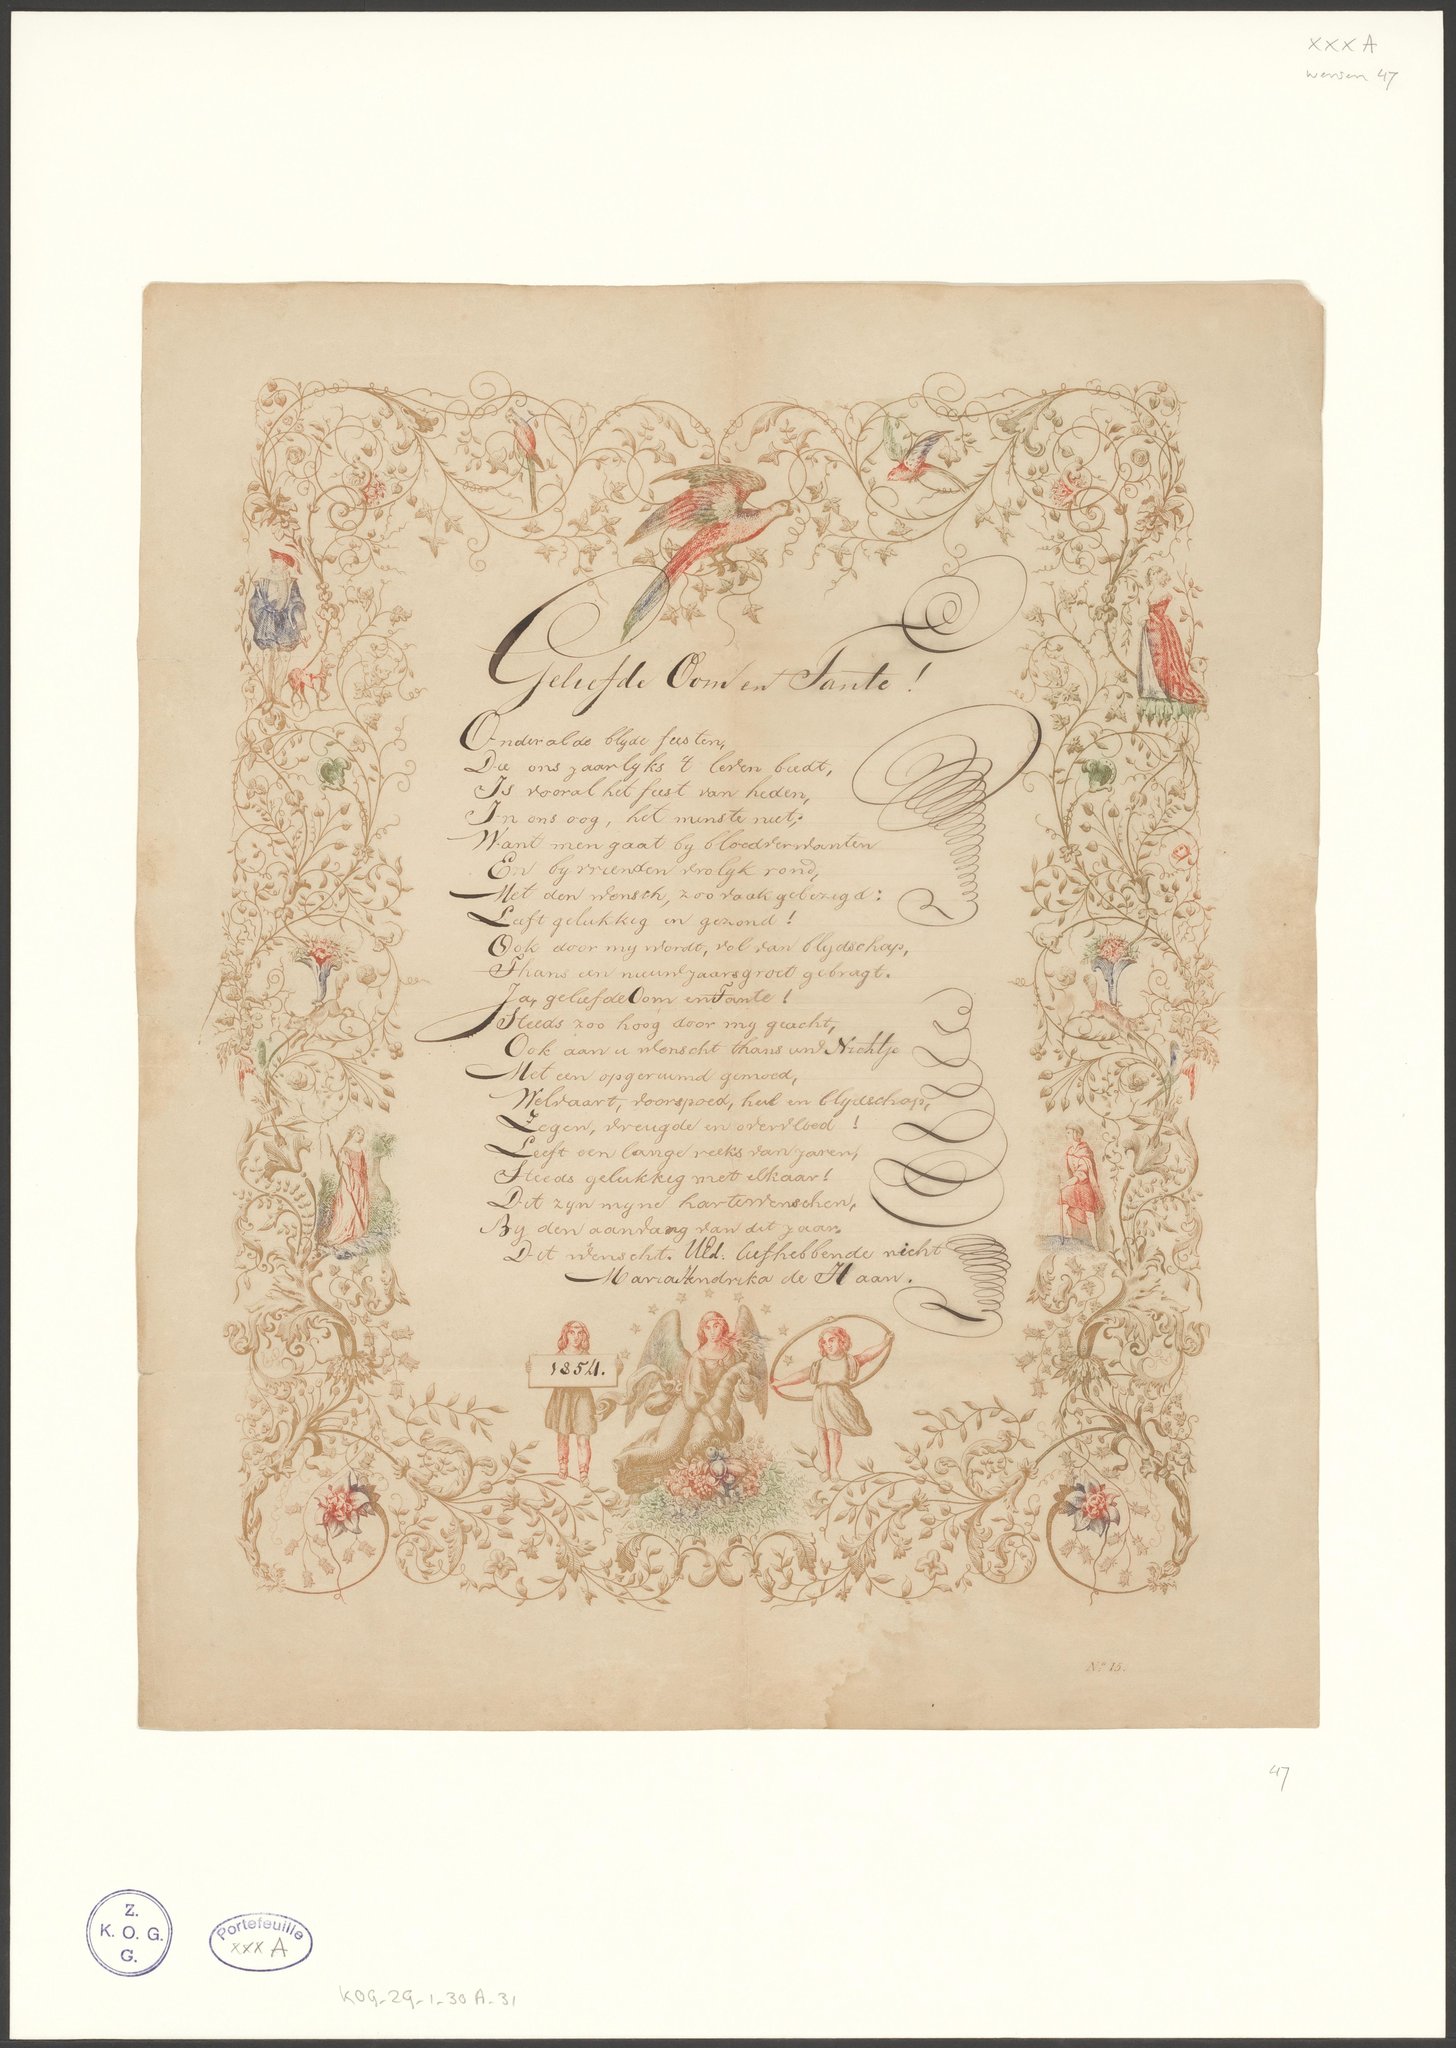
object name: print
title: Nieuwjaarswens van Maria Hendrika de Haan, 1854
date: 1854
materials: ink, paper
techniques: lithograph, handwriting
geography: netherlands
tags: birds, january 1 (~ festivities), ornament derived from plant forms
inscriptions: collector's mark: Lugt 1641, collector's mark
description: Nieuwjaarswens van Maria Hendrika de Haan, 1854. Gericht aan haar oom en tante. Voorgedrukt blad met een kader van ranken, bloemen, vogels en middeleeuwse figuren. Onderaan een engel en twee meisjes. Genummerd rechtsonder: No. 15. Onderwerpsrubrieken binnen de Atlas Zeden en Gewoonten: Nieuwjaars- en kermiswenschen.